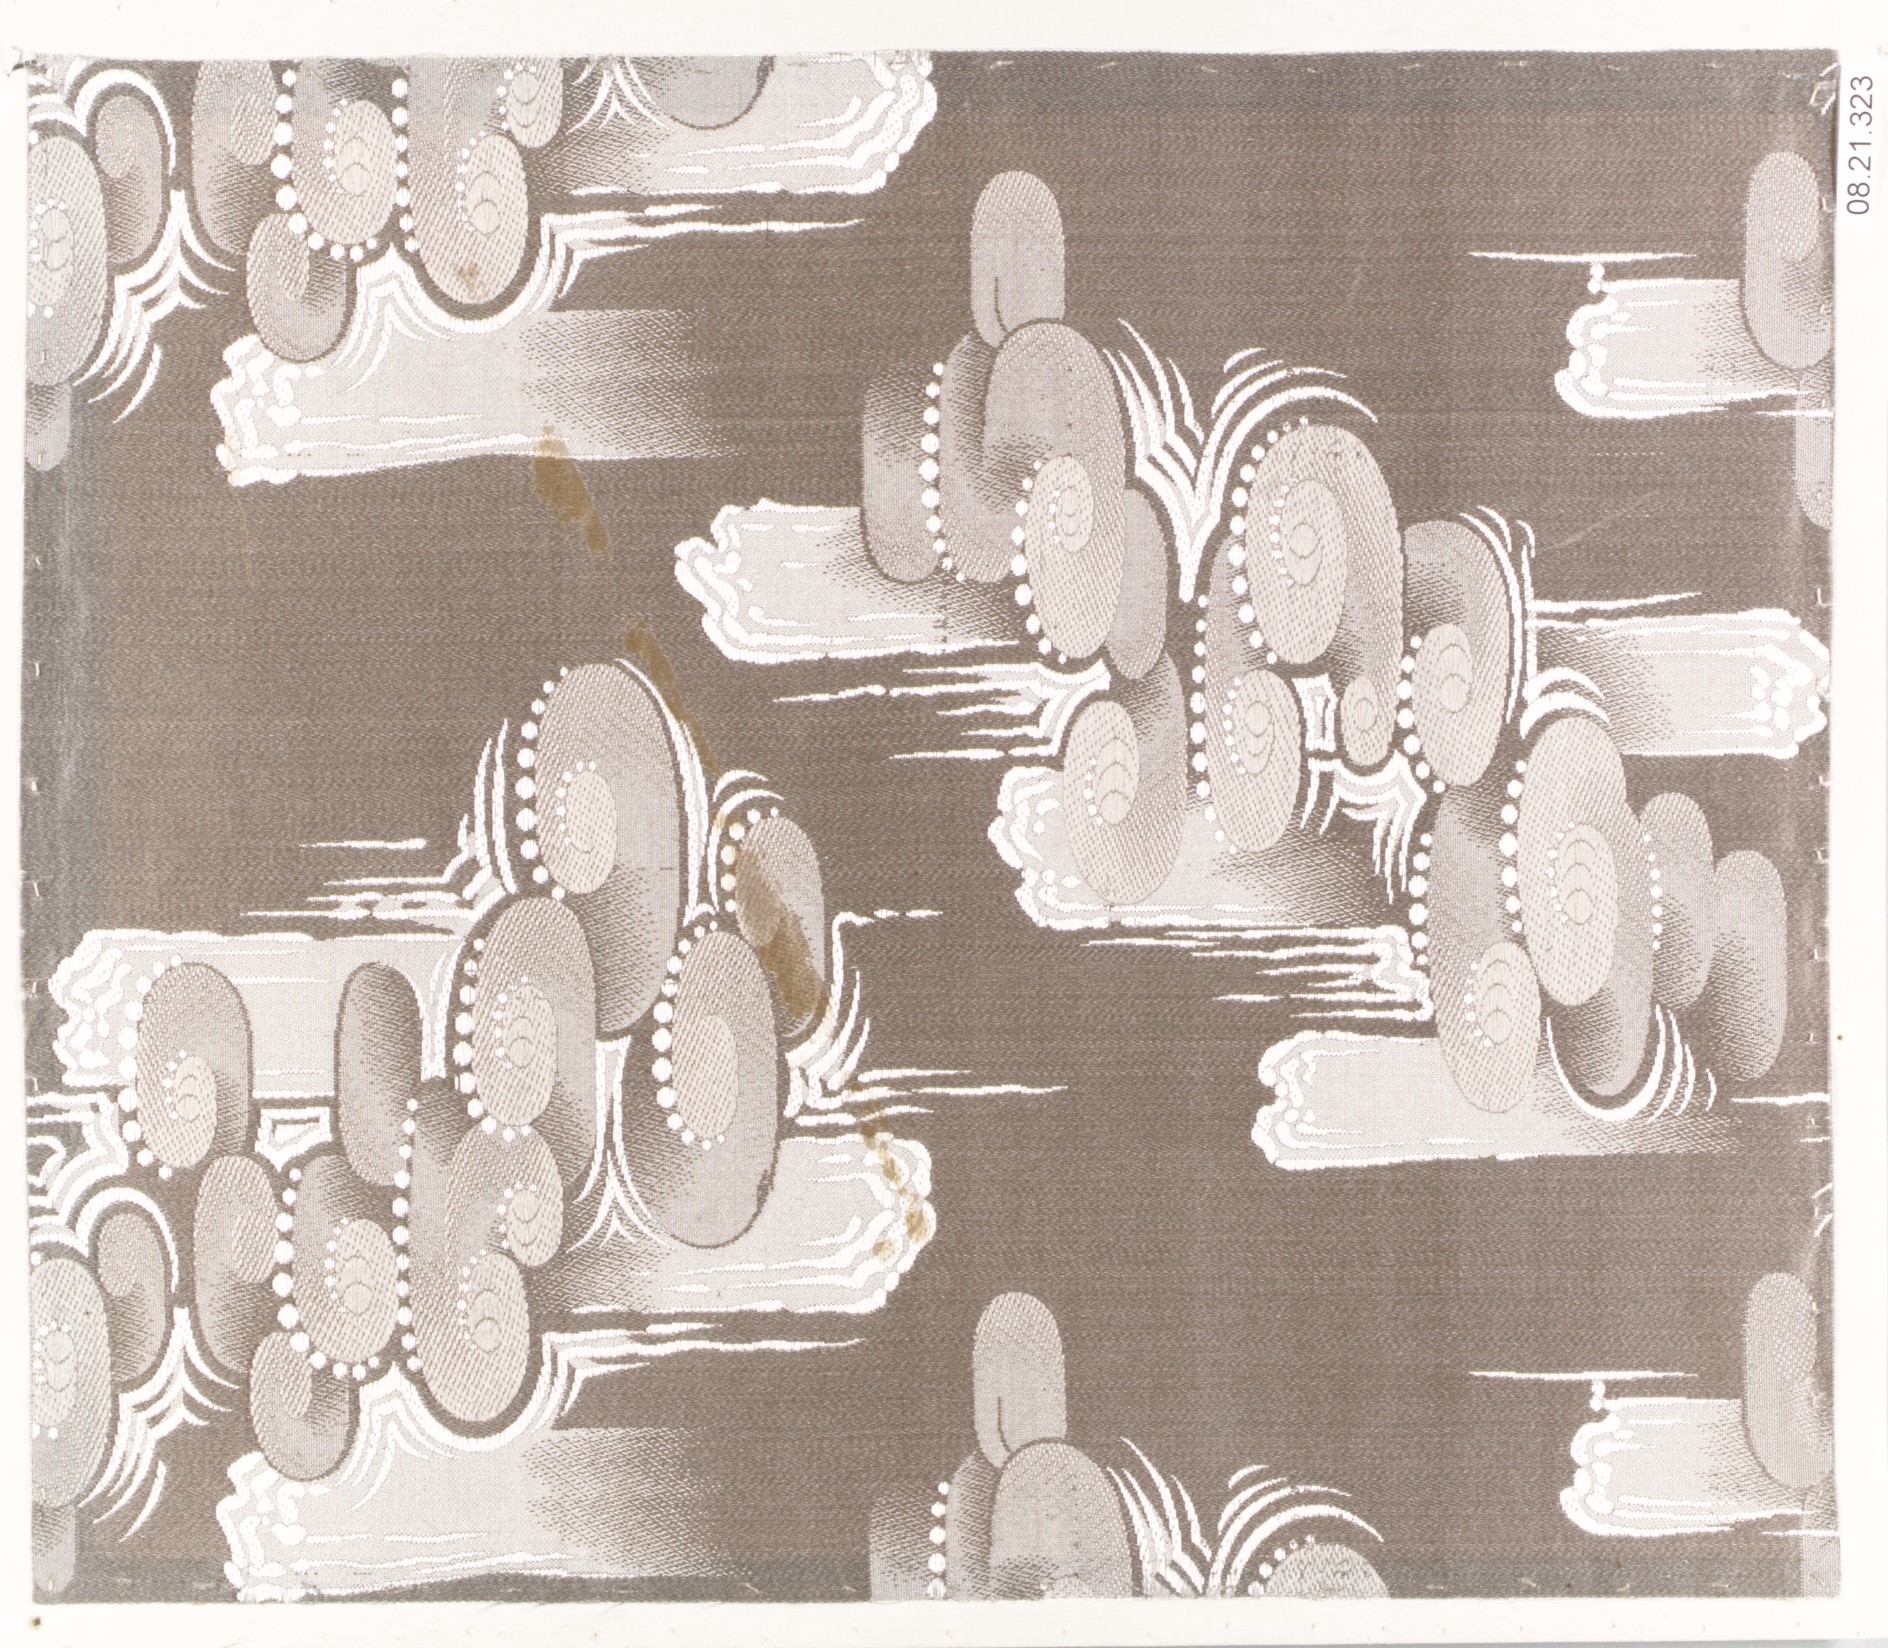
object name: textile sample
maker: Anonymous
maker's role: designer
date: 1900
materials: silk